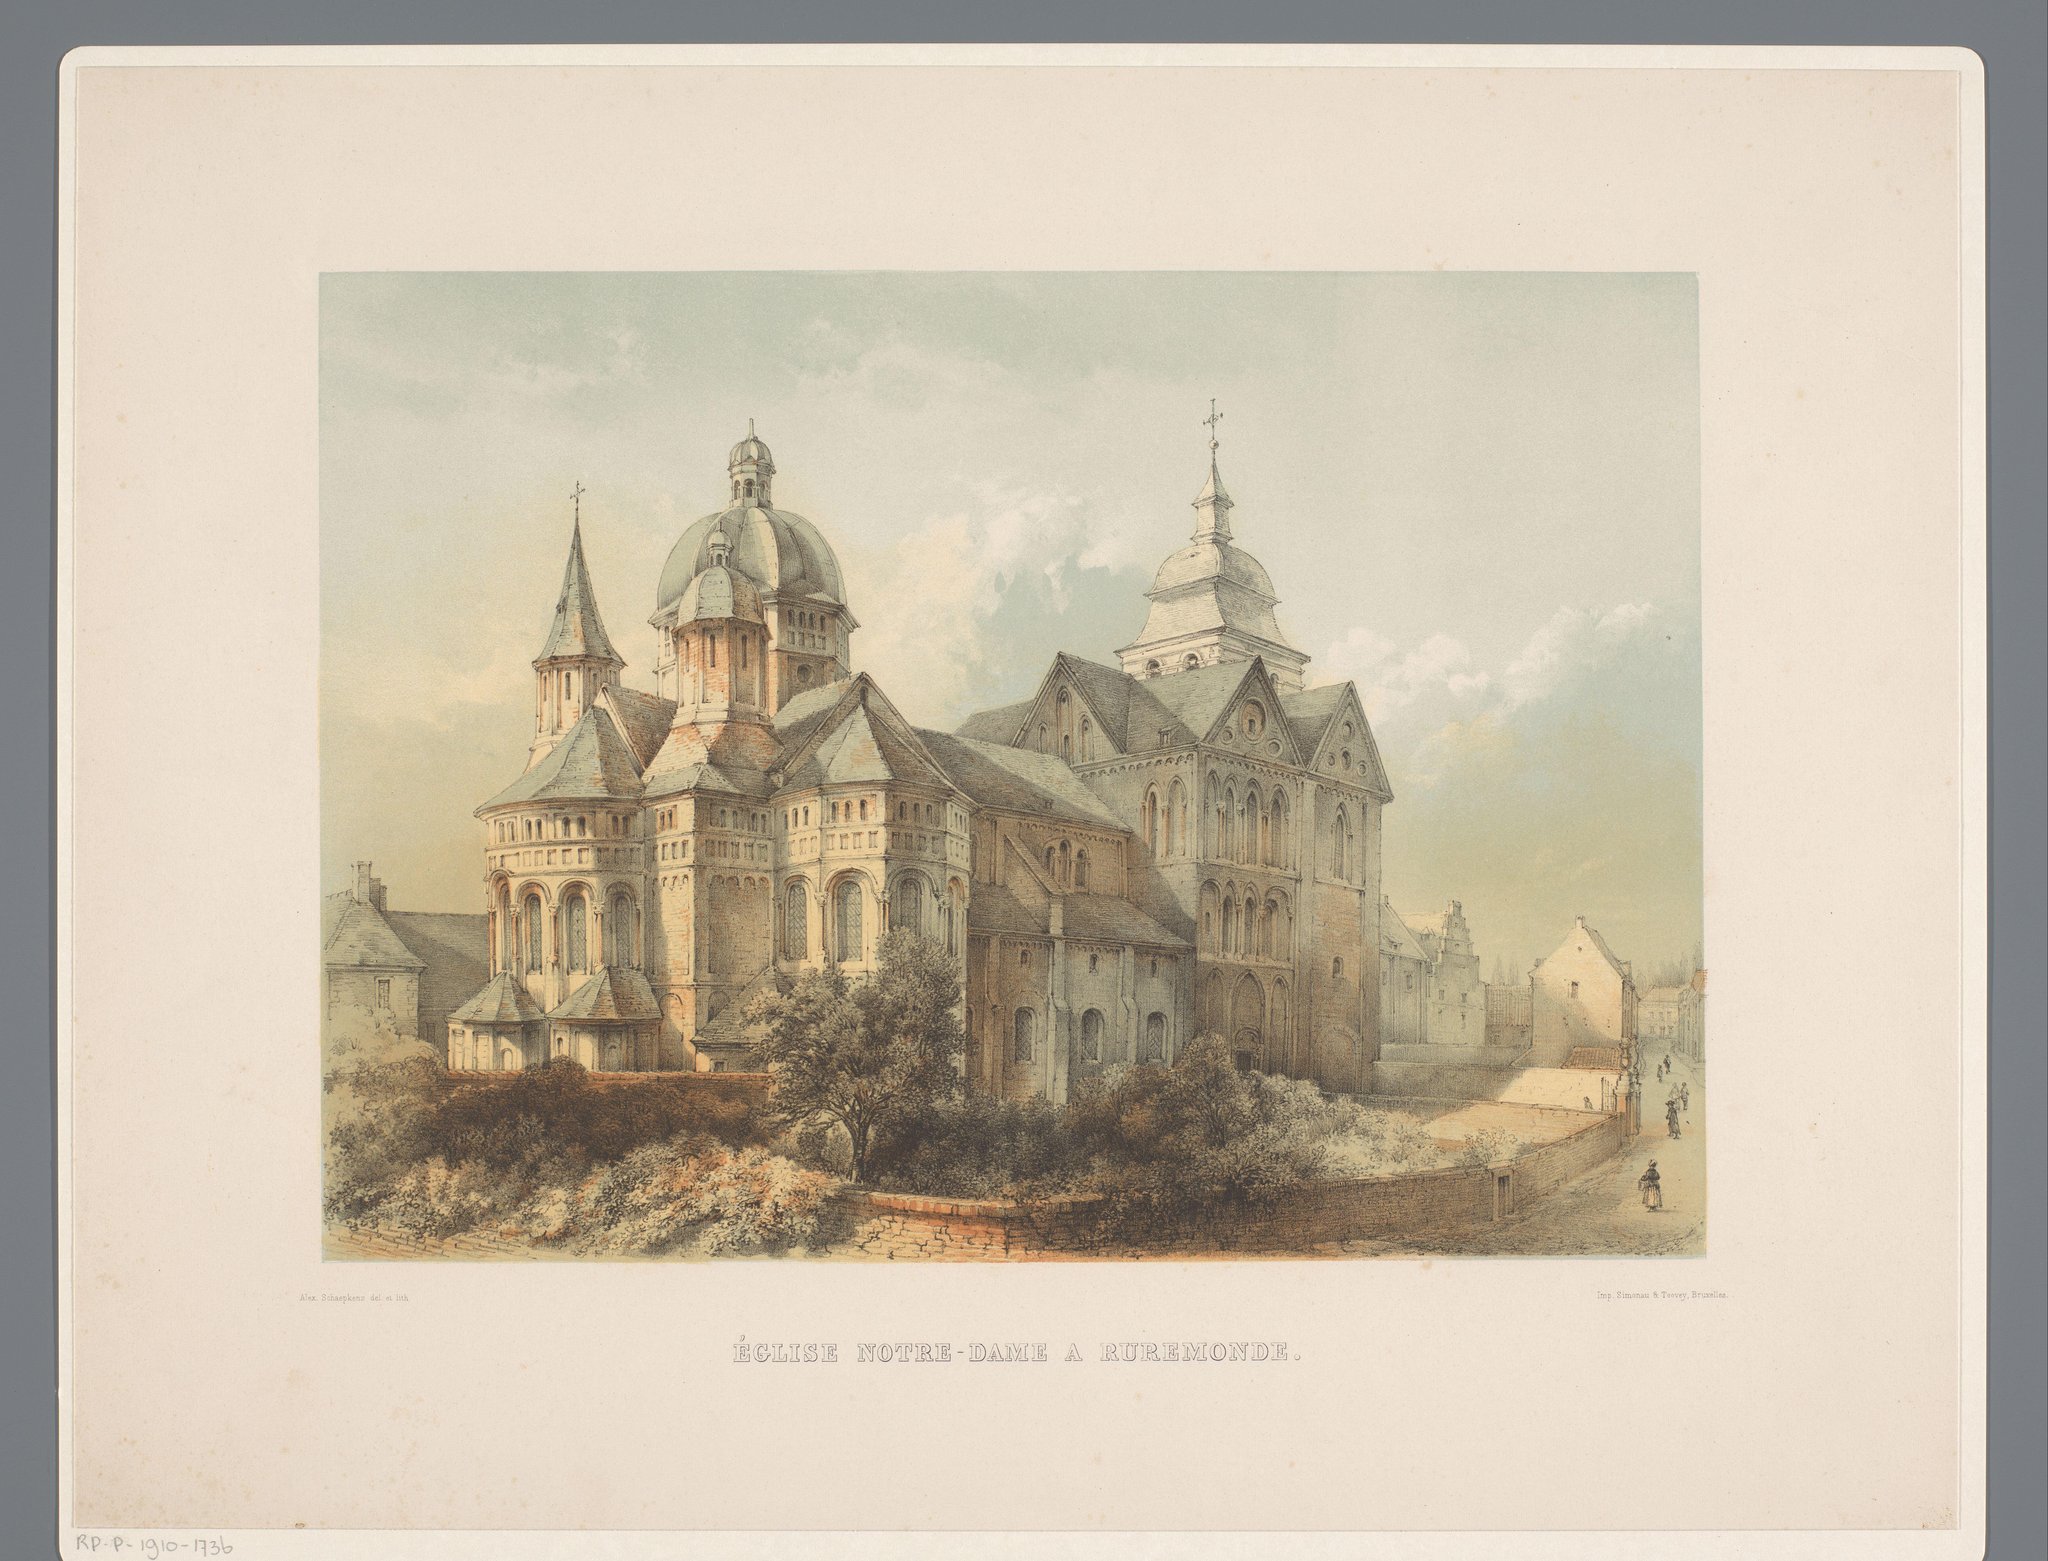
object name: print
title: Anciens Monuments d'Architecture du Onzième Siecle au Treizieme Siecle dans le Limbourgs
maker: alexander schaepkens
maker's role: draughtsman, print maker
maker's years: 1815-1899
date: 1855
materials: paper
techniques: lithograph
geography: brussels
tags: church (exterior)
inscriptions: collector's mark: Lugt 2228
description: Gezicht op de Onze Lieve Vrouwe Munsterkerk (voor de Cuypers-restauratie in 1863-1890). Links de apsis, rechts de ingangspartij.